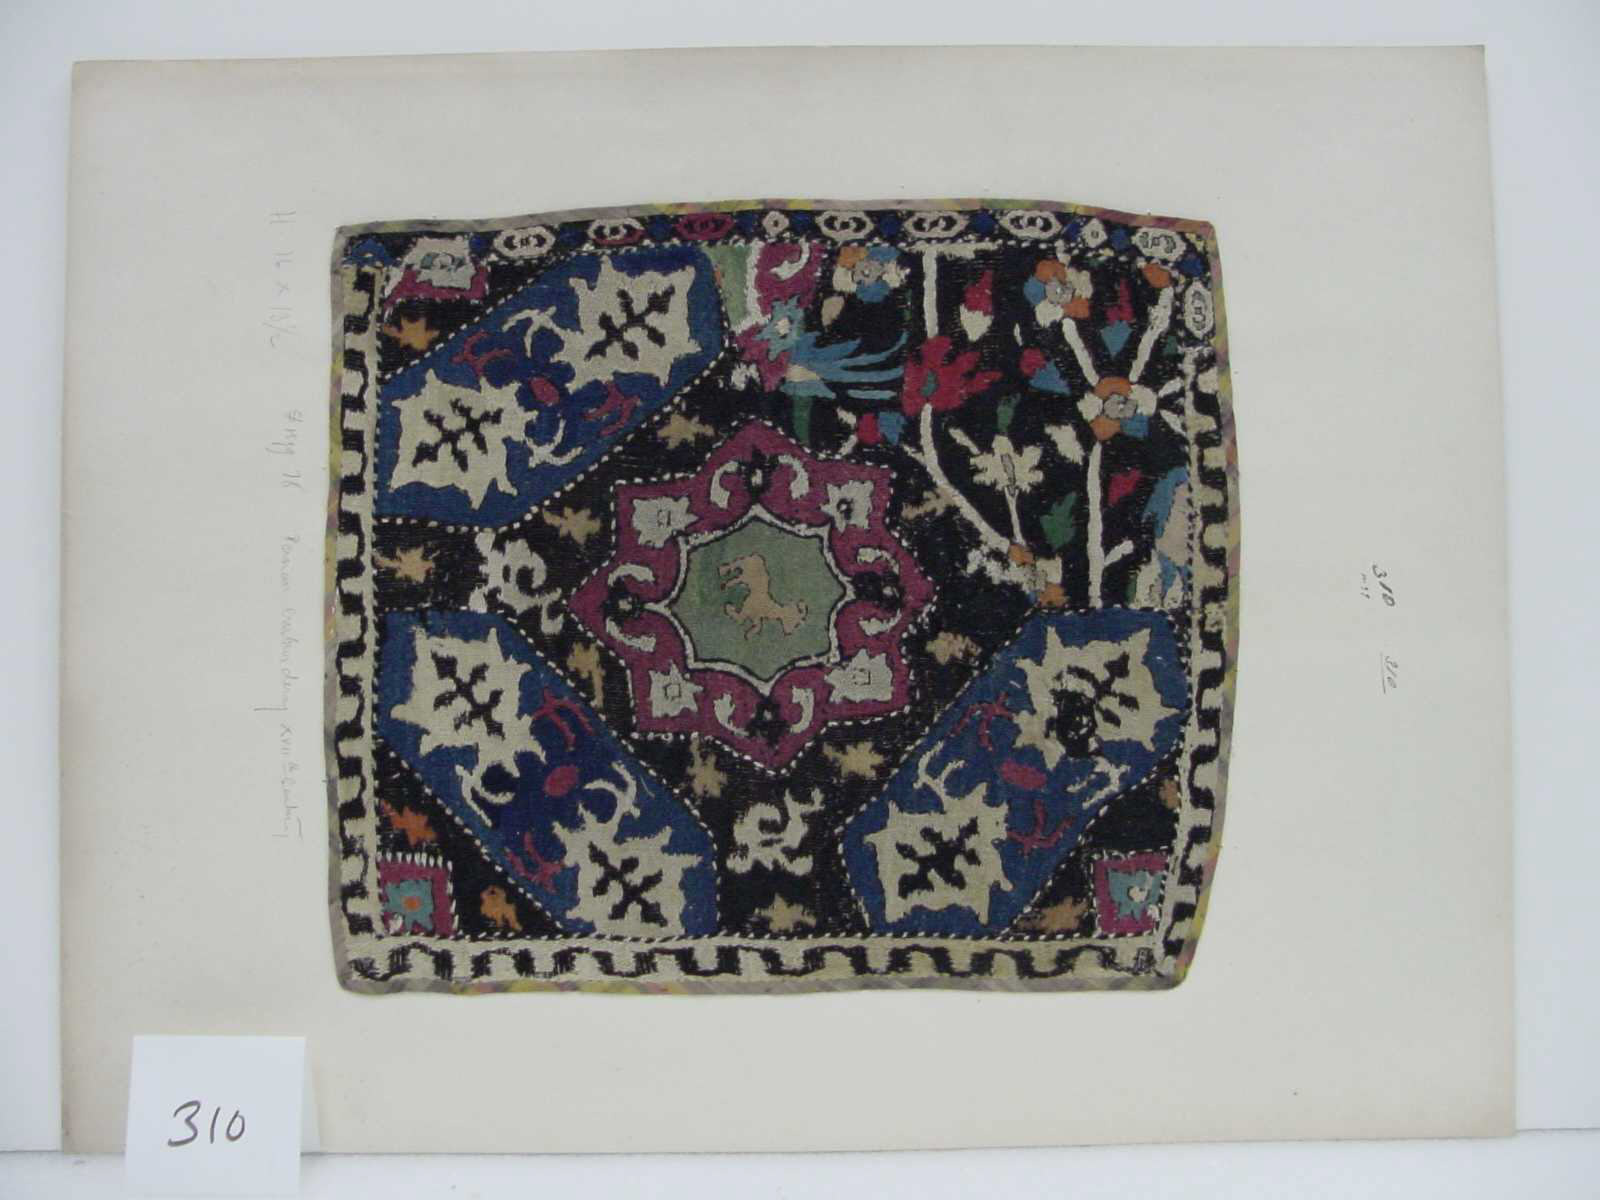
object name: textile fragment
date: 1601-1700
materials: silk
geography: iran